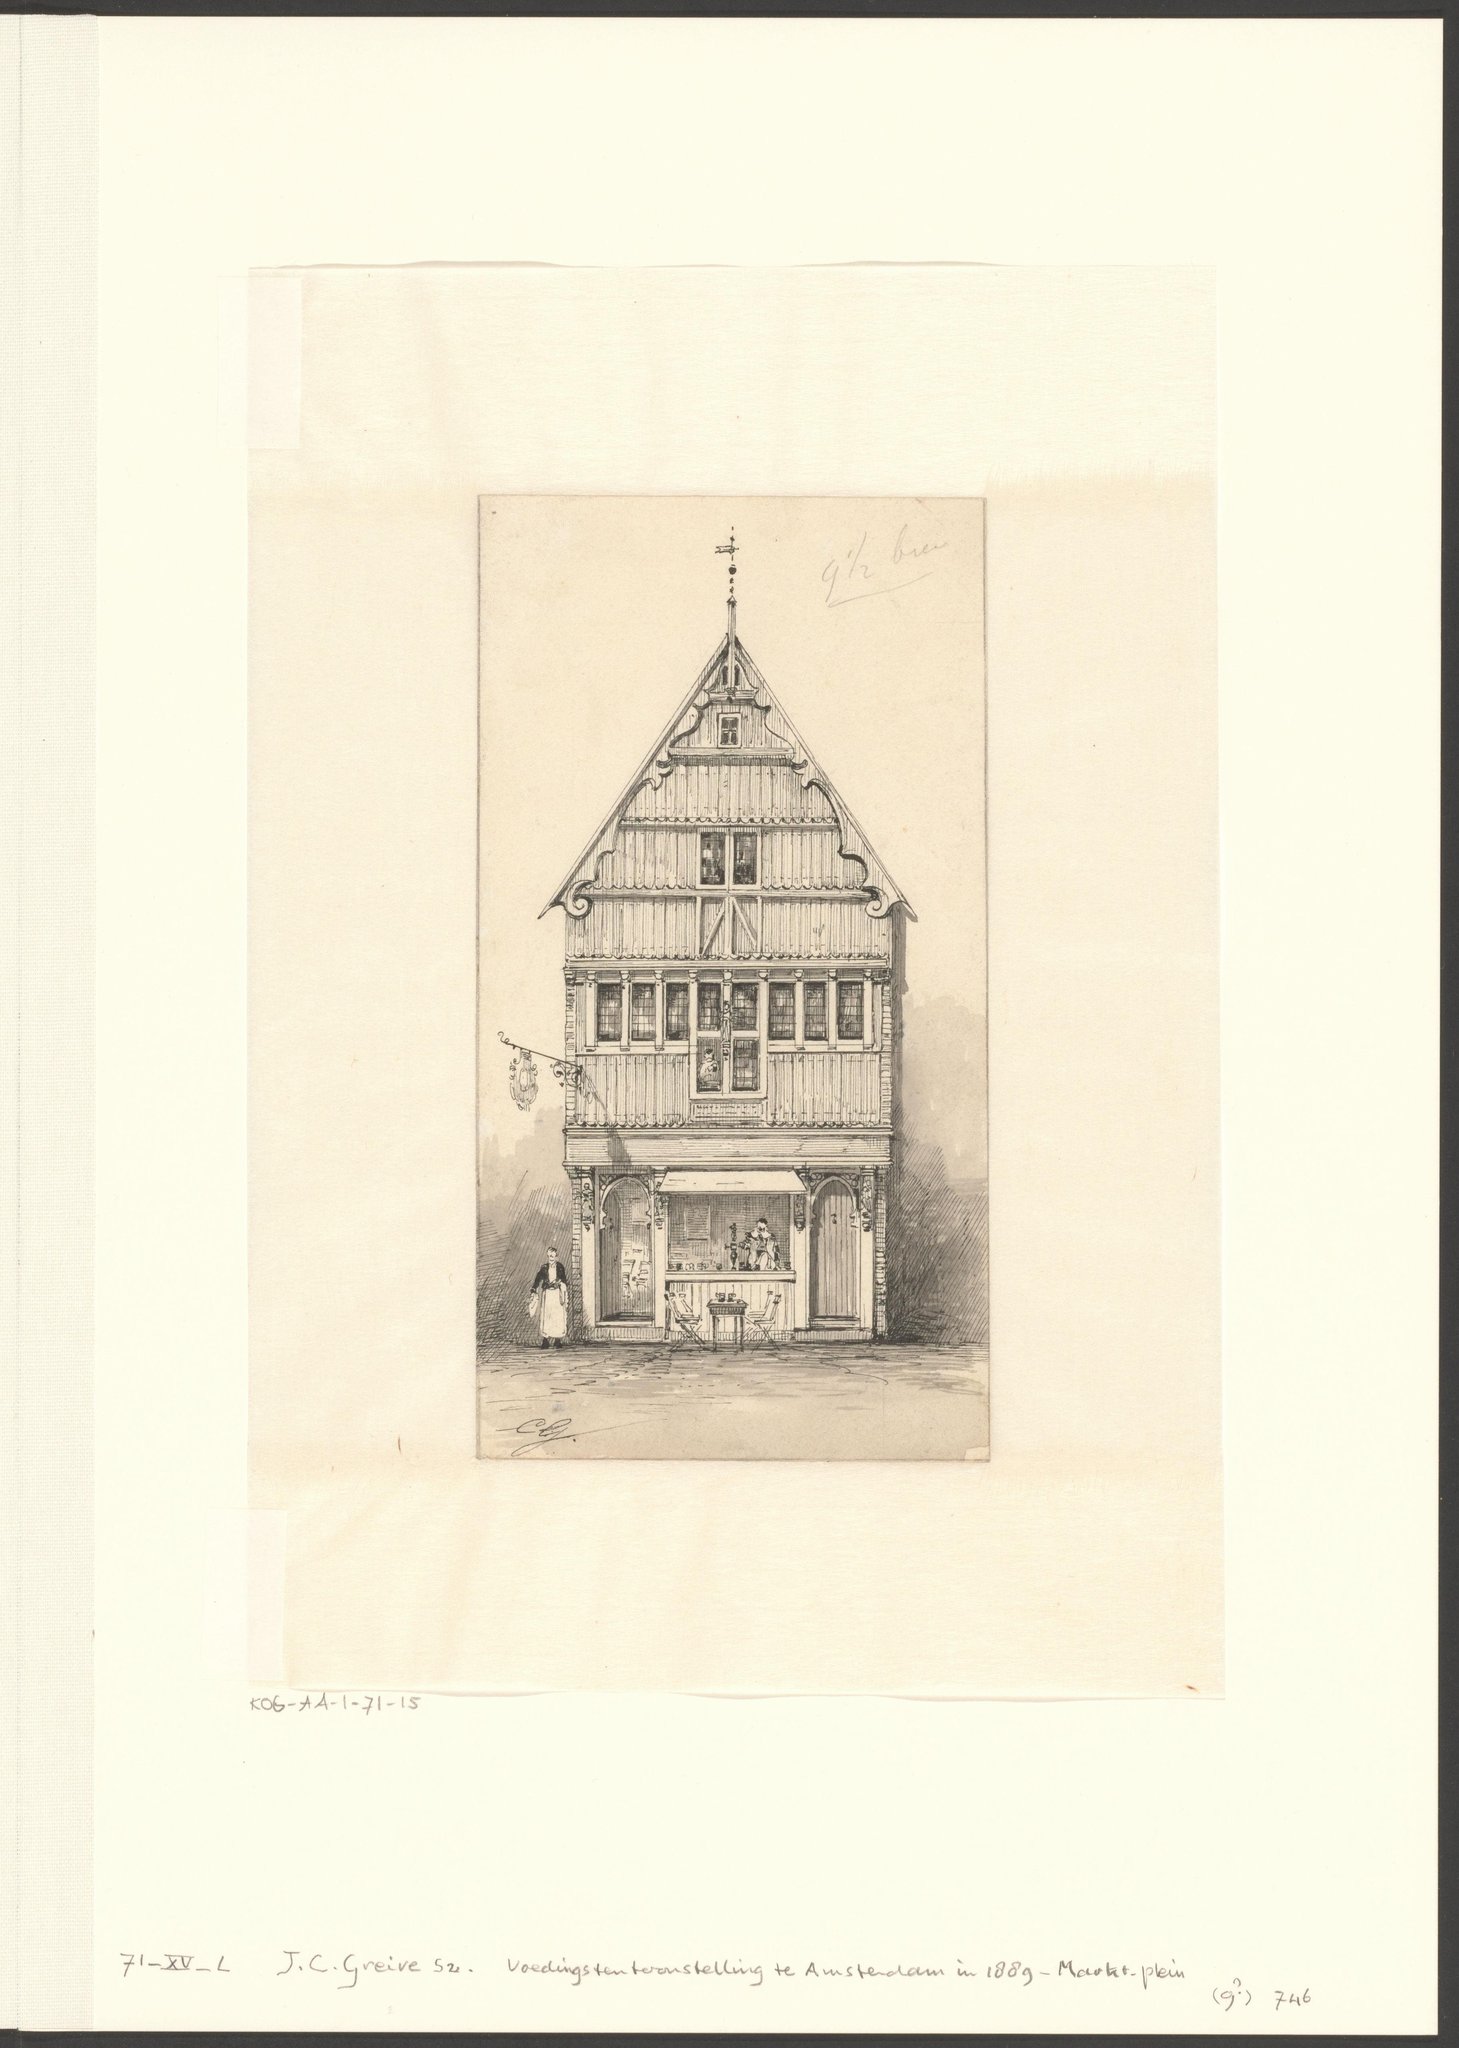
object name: drawing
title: Gezicht op een oud-Hollandse taveerne gebouwd voor de tentoonstelling van Voedingsmiddelen op het Museumplein van 1887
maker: johan conrad greive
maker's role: draughtsman, painter, print maker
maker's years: 1837-1891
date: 1887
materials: ink, paper, pencil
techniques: brush, pen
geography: amsterdam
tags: trade exhibition, industries fair, city-view in general; 'veduta'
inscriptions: signature: ‘C.G.’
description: Onderwerpsrubriek binnen de Atlas Amsterdam: Tentoonstellingen (chronologisch).